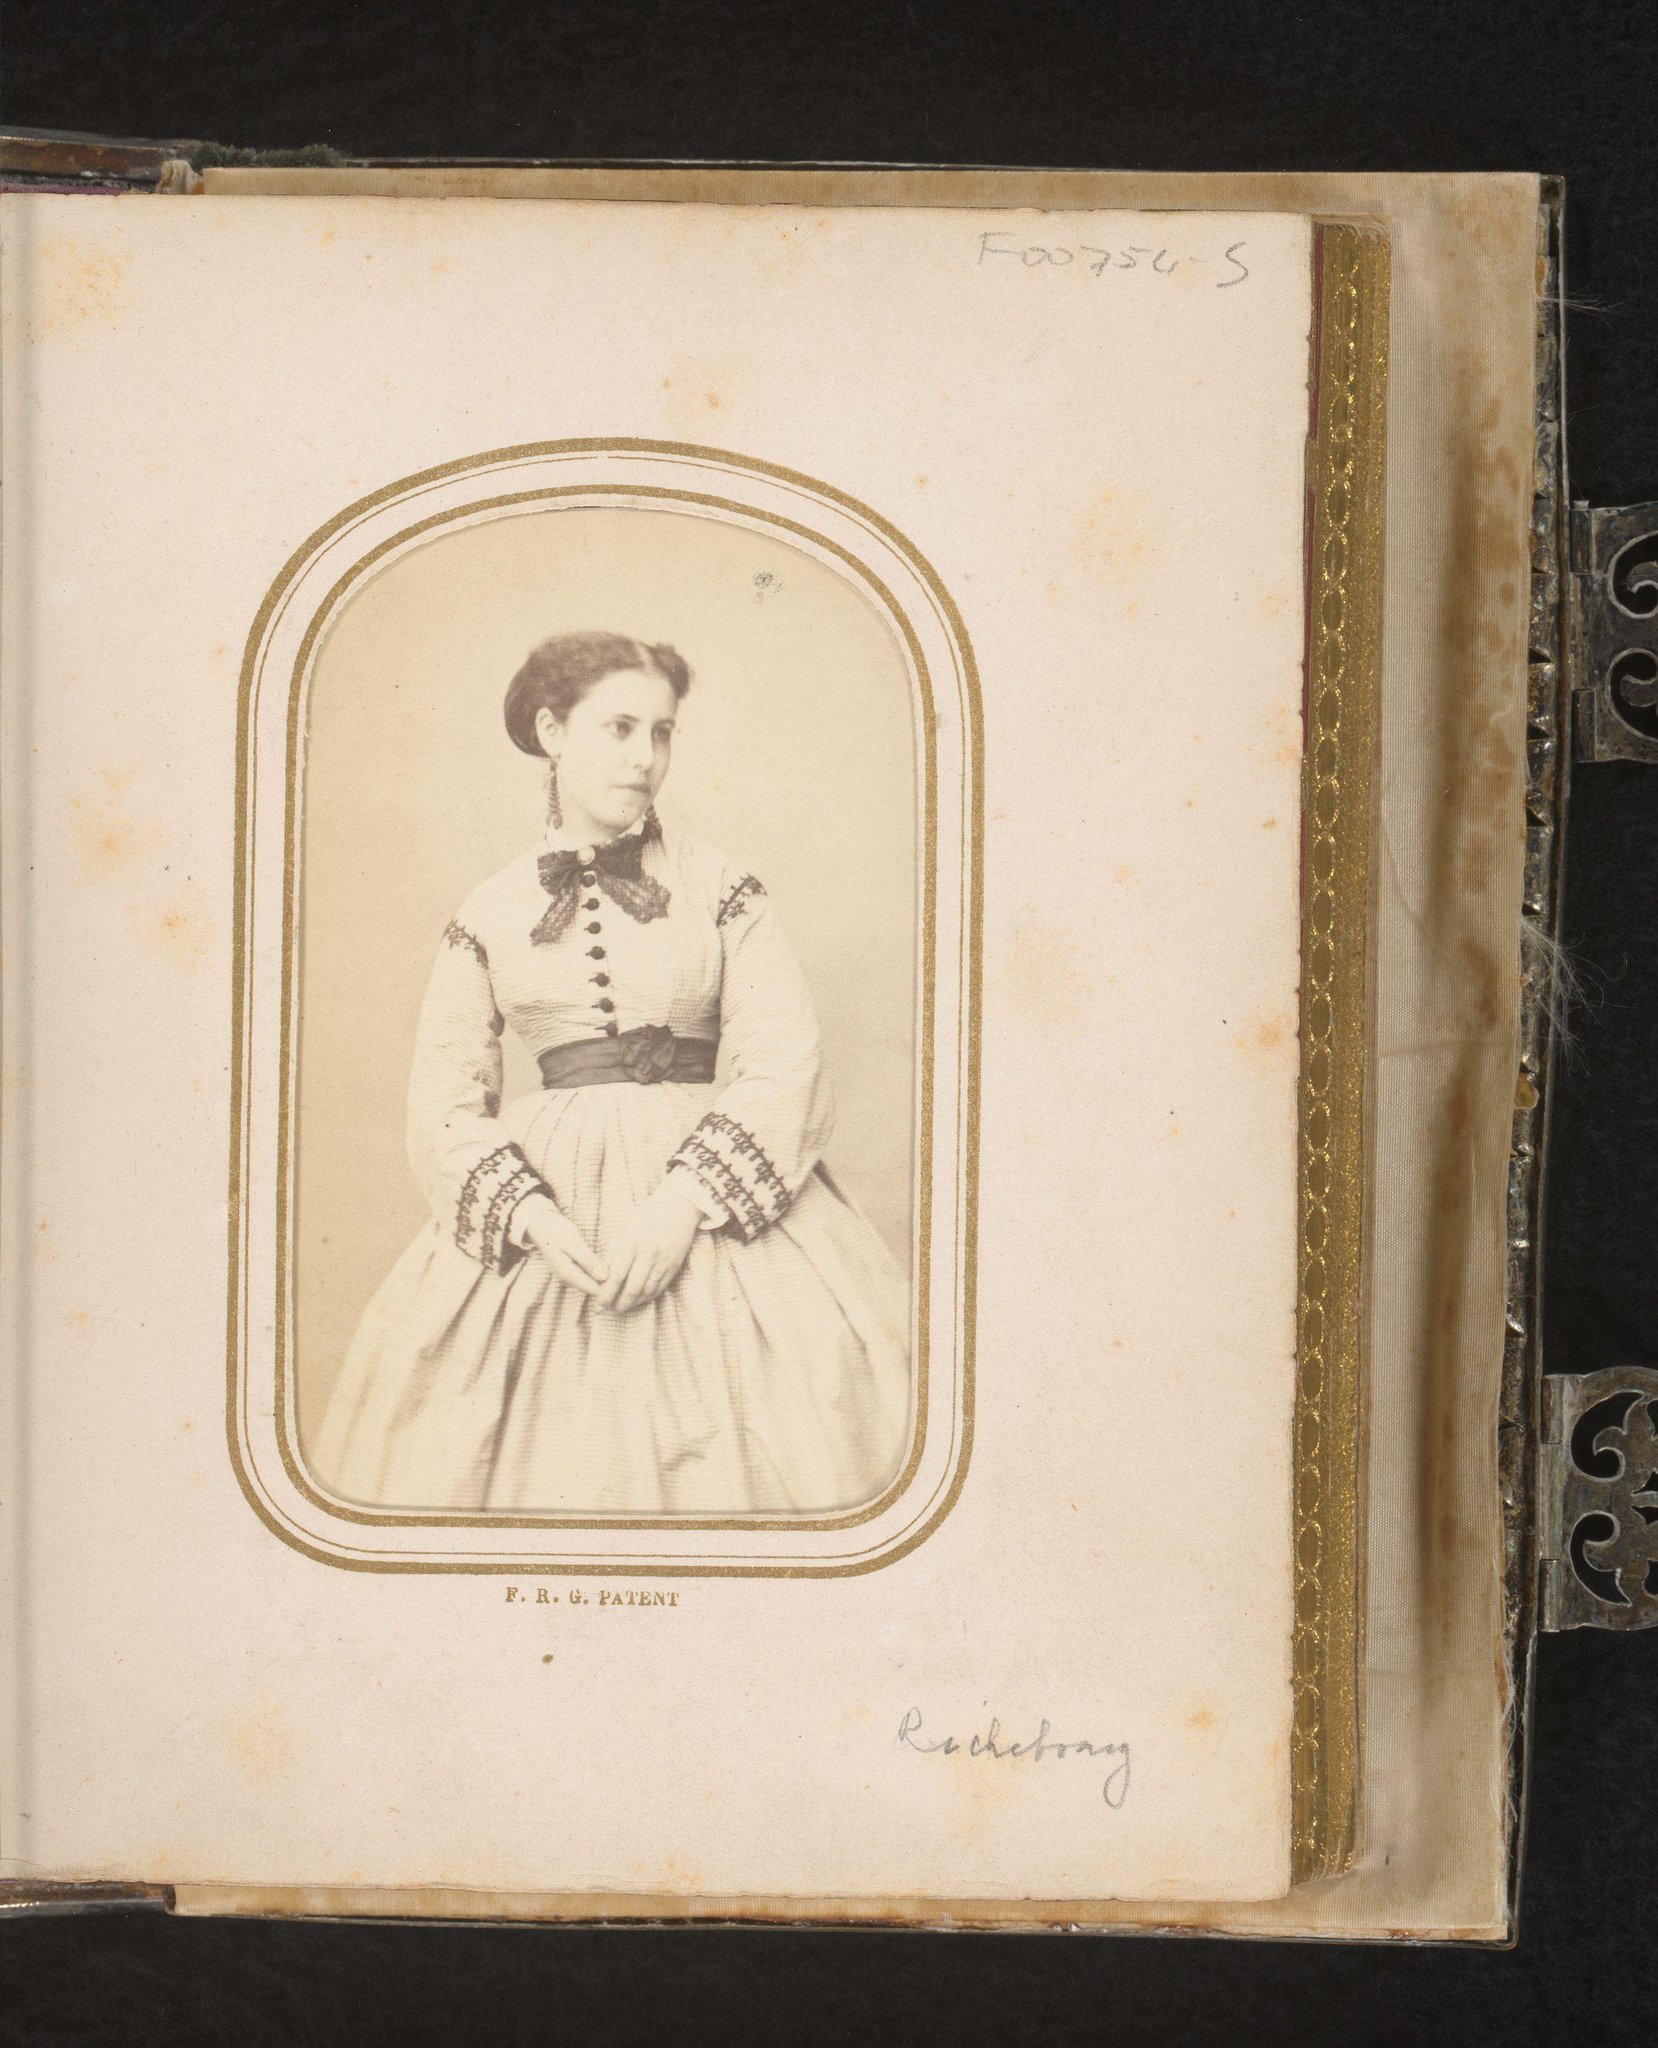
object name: photograph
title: Portret van een vrouw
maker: pierre-ambroise richebourg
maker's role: fotograaf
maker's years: 1810-1875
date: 1855-1872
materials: cardboard, photographic support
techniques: albumen print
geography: paris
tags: historical persons - bb - woman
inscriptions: inscription: ‘Paris, 29 Quai de l'Horloge(fabrique d'instruments optique, physique, mathematique et appareils de photographie)’